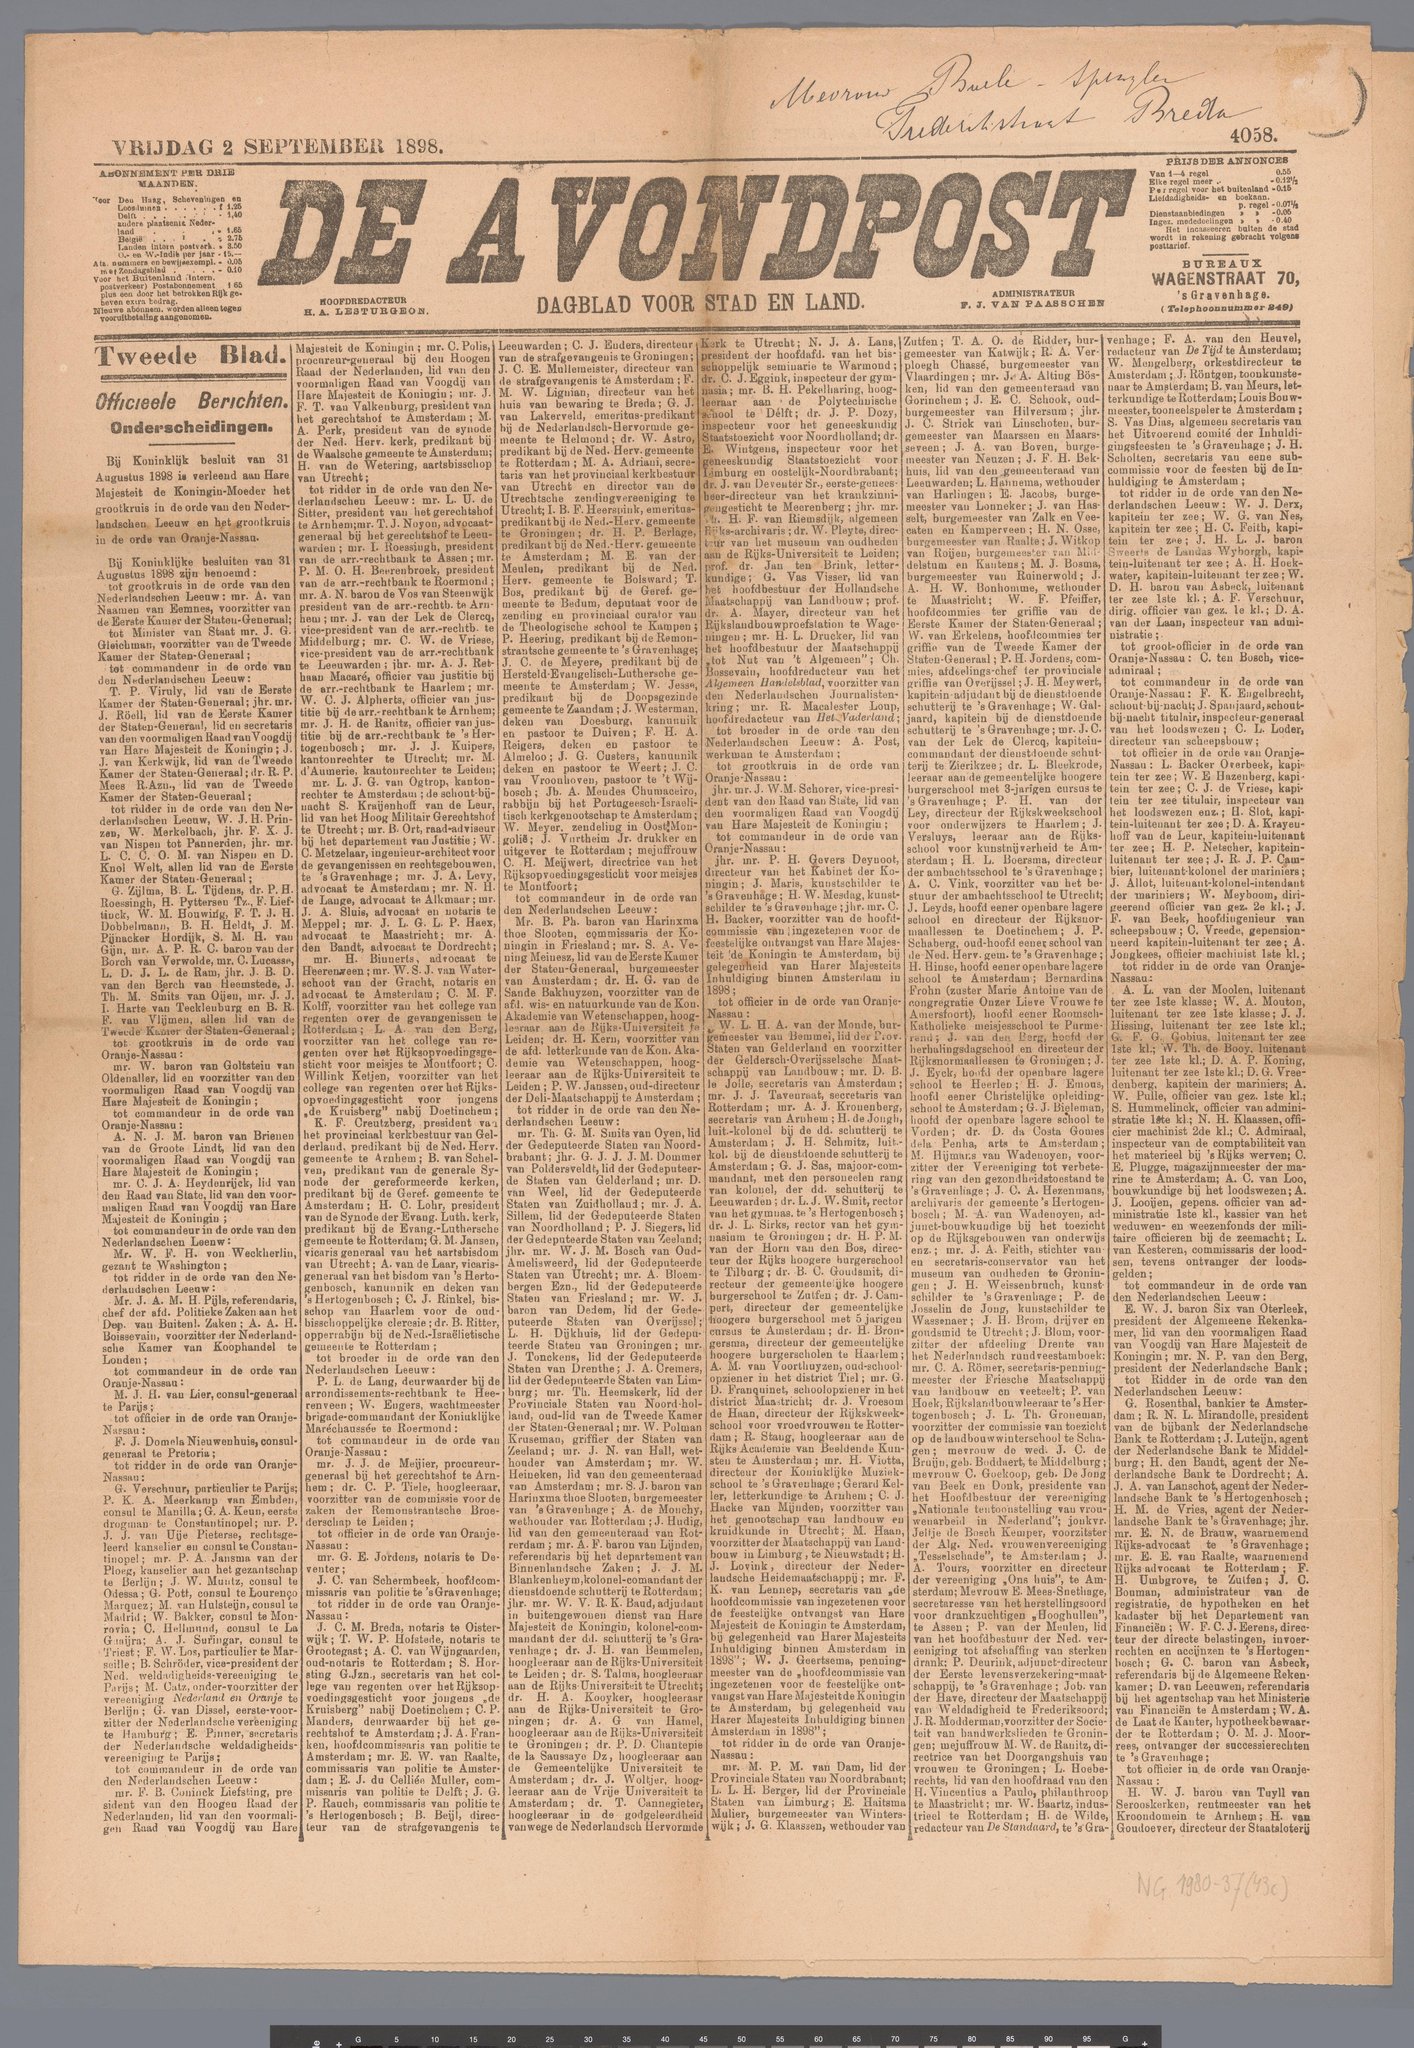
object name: newspaper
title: de Avondpost; dagblad voor stad en land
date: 1898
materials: paper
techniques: printing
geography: the hague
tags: print maker, wilhelmina of the netherlands, netherlands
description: Eén van een serie kranten, nrs. 4056 t/m 4073, van "de Avondpost" met berichten over de inhuldiging van koningin Wilhelmina 1898.